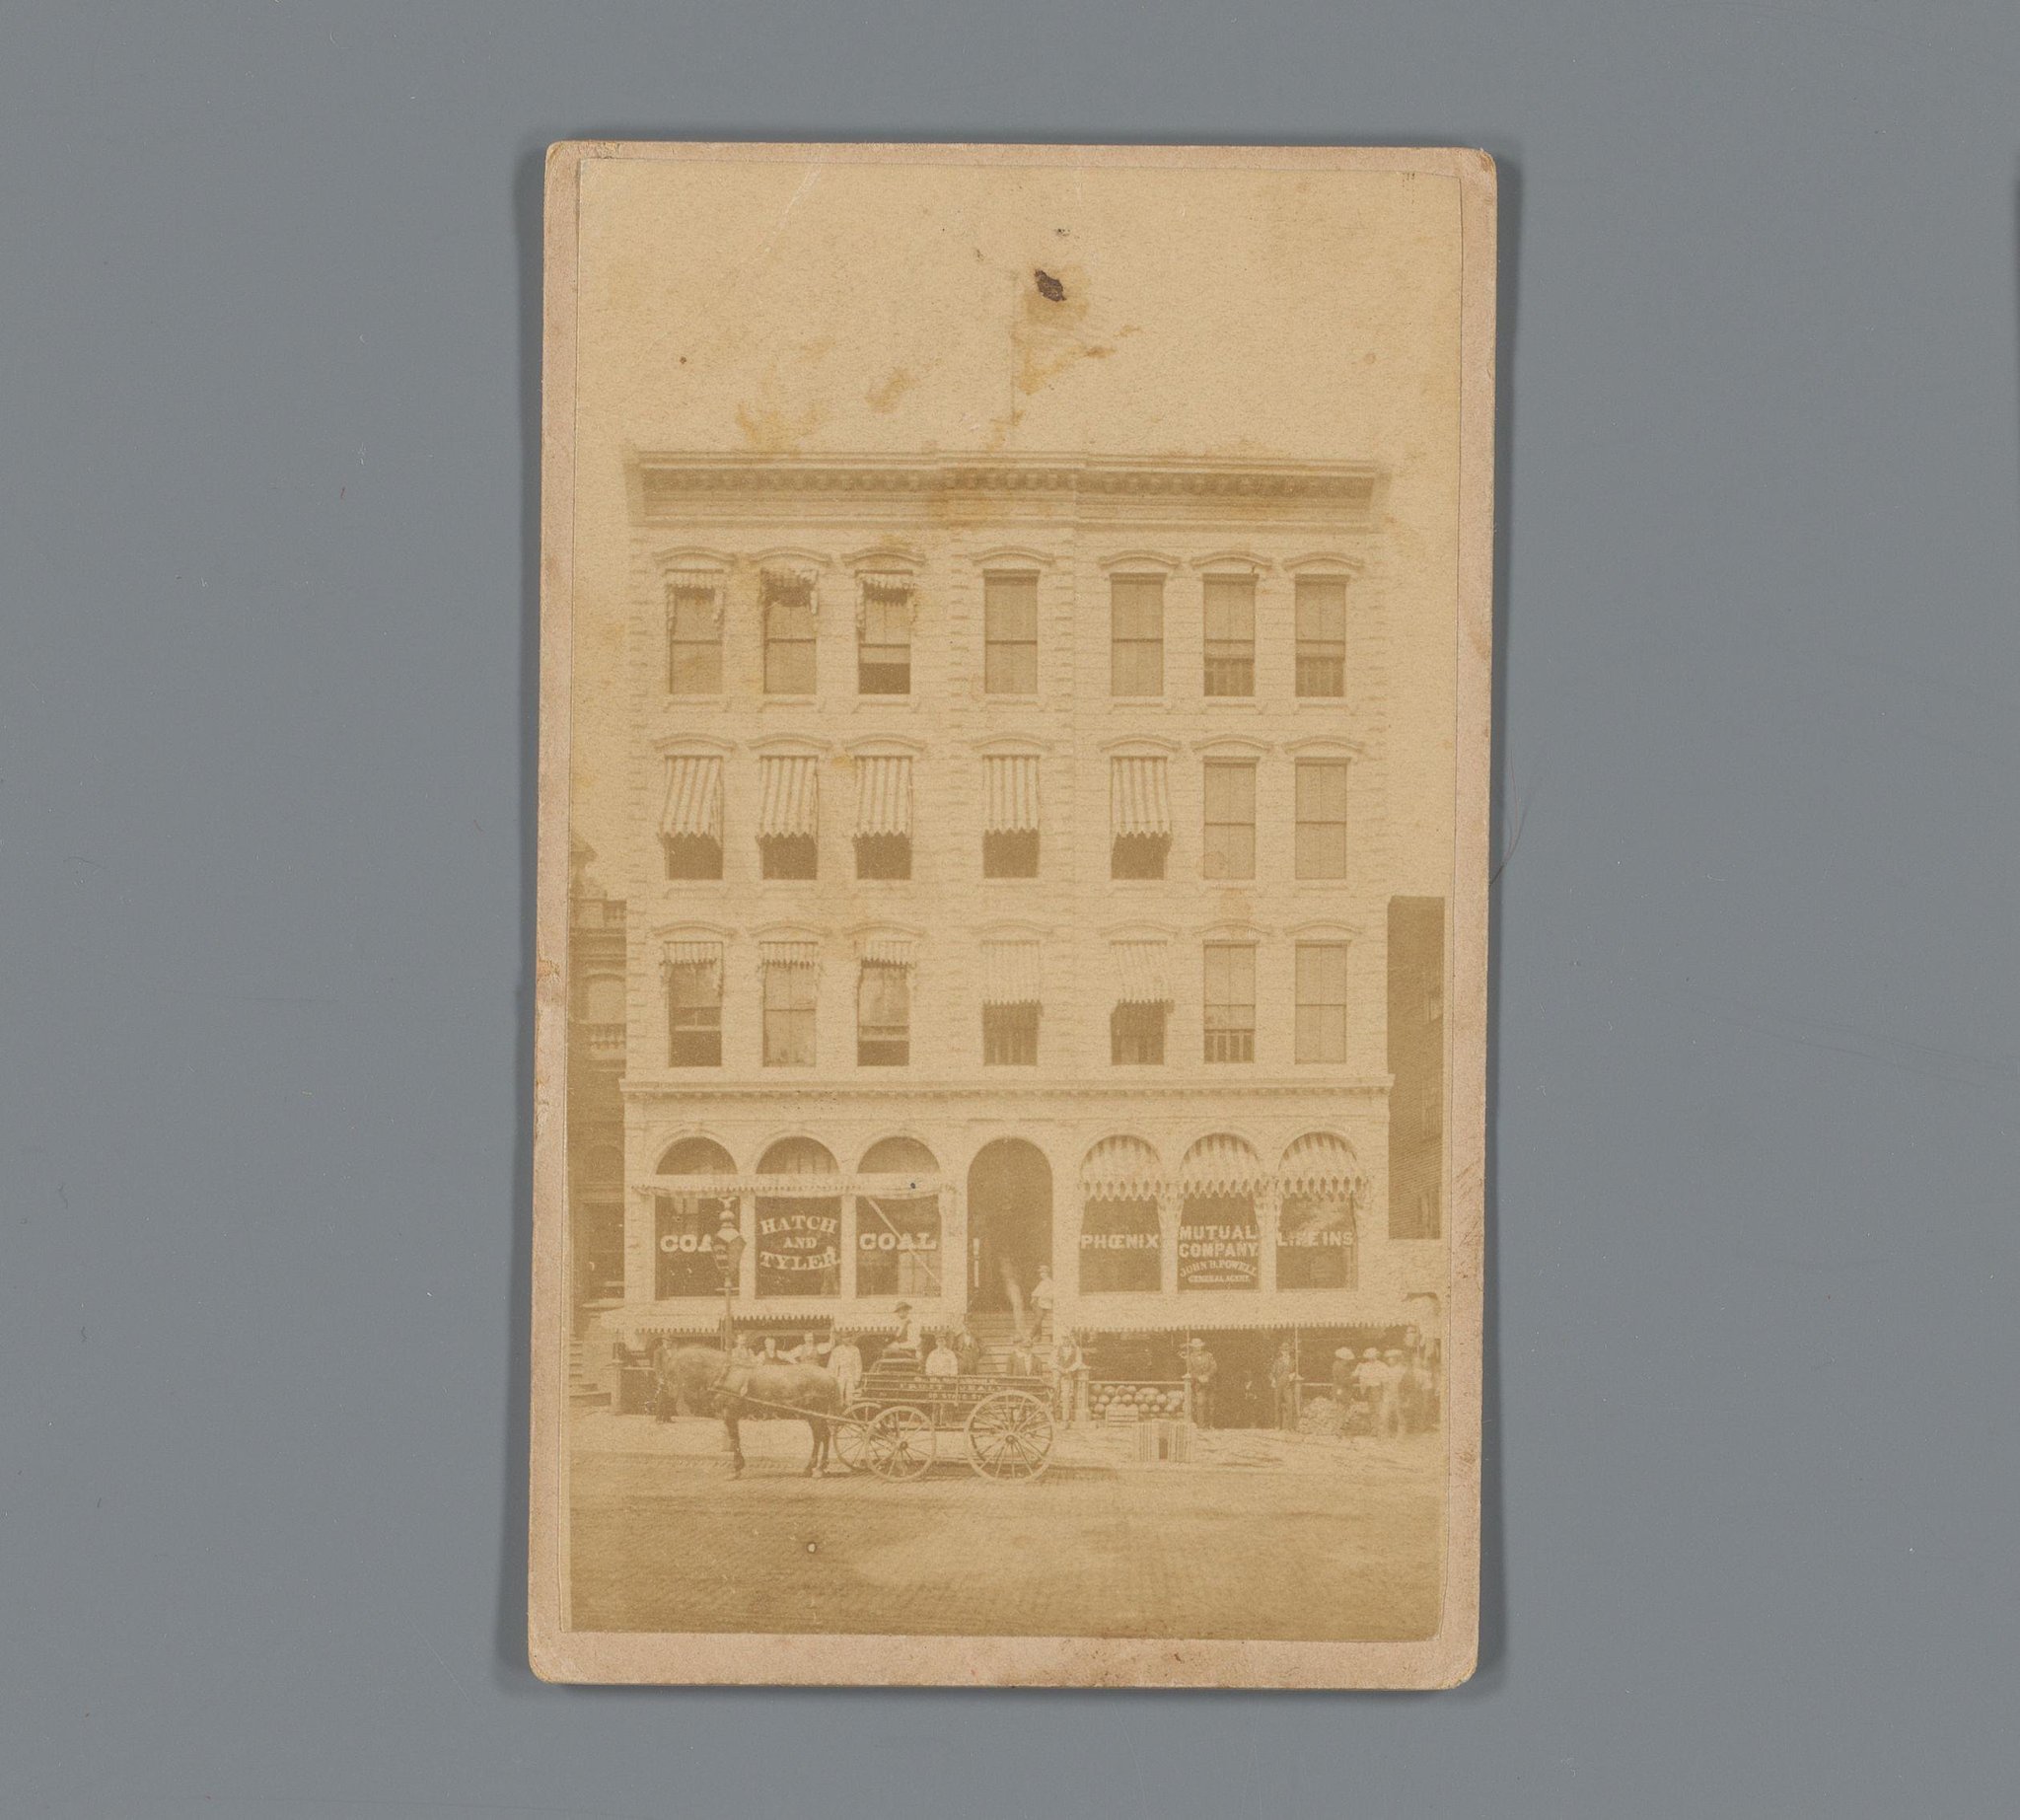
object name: carte de visite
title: Reclame voor de fruithandel van S.W. Gergory met gezicht op zijn winkel in Hartford, Connecticut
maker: Anonymous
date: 1850-1915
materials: cardboard, photographic support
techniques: albumen print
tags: shop, store, advertising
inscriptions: inscription: ‘(...)’